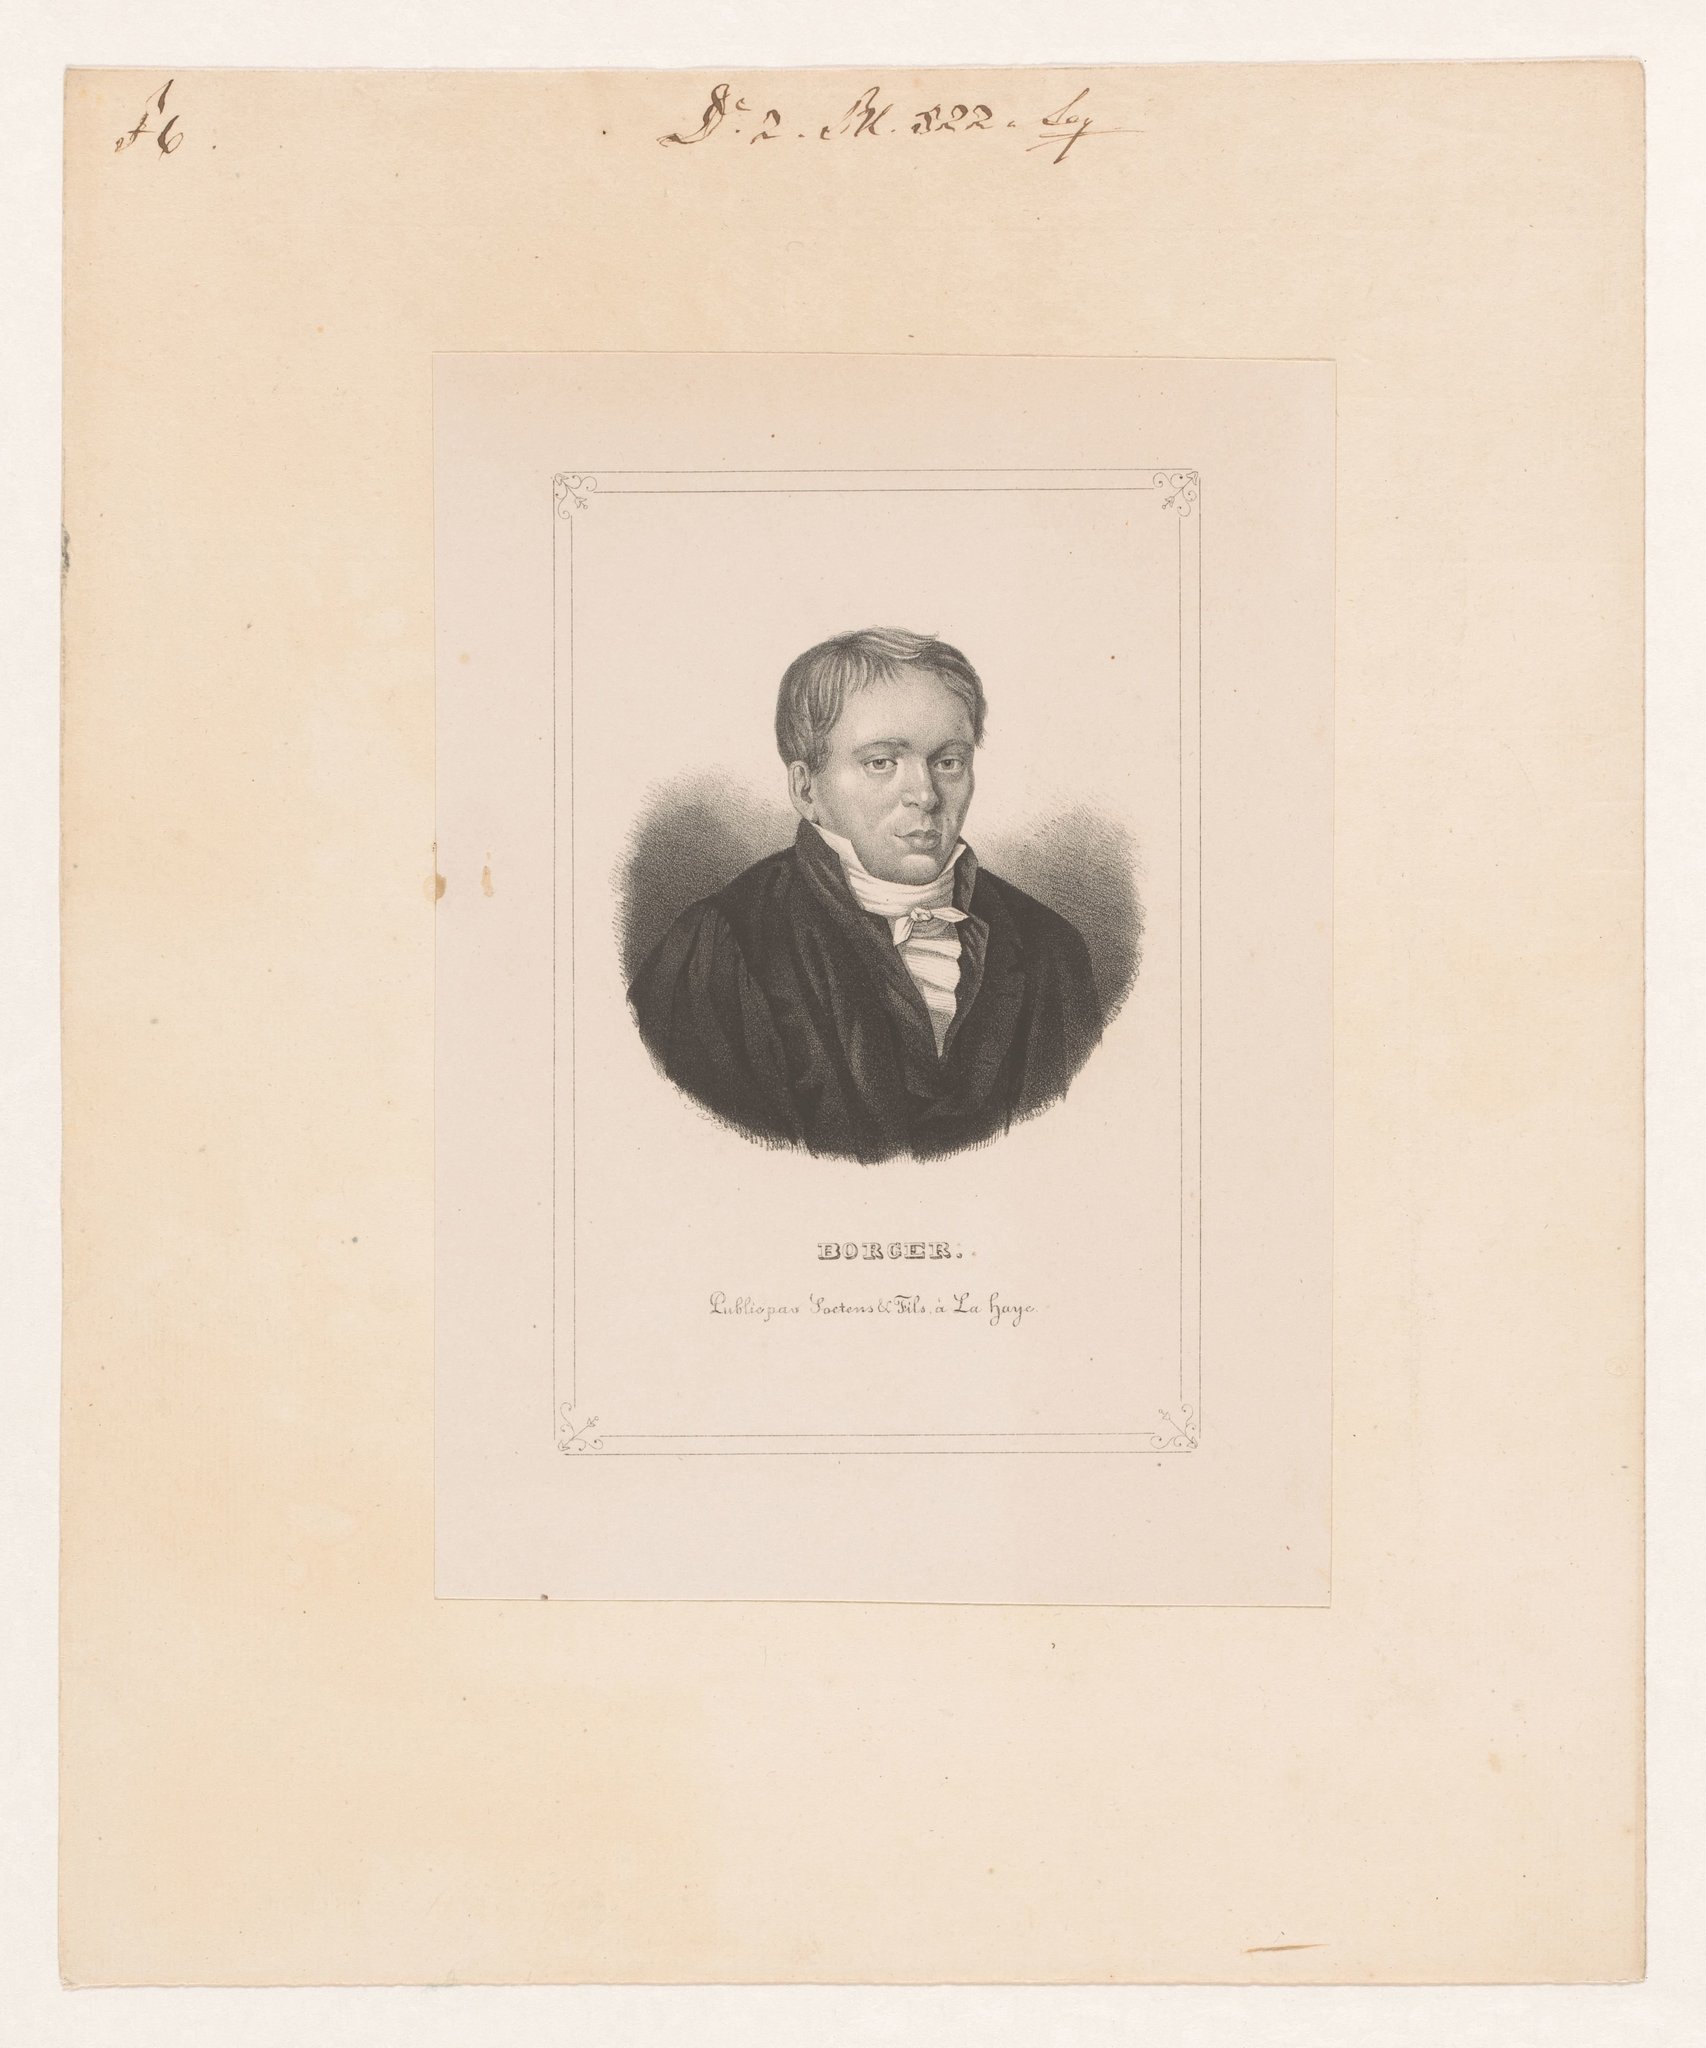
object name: print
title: Borger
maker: hendrik frederik sartor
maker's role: draughtsman, print maker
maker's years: 1818-1881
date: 1837-1840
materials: paper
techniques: lithograph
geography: the hague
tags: historical persons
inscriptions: collector's mark: Lugt 2228